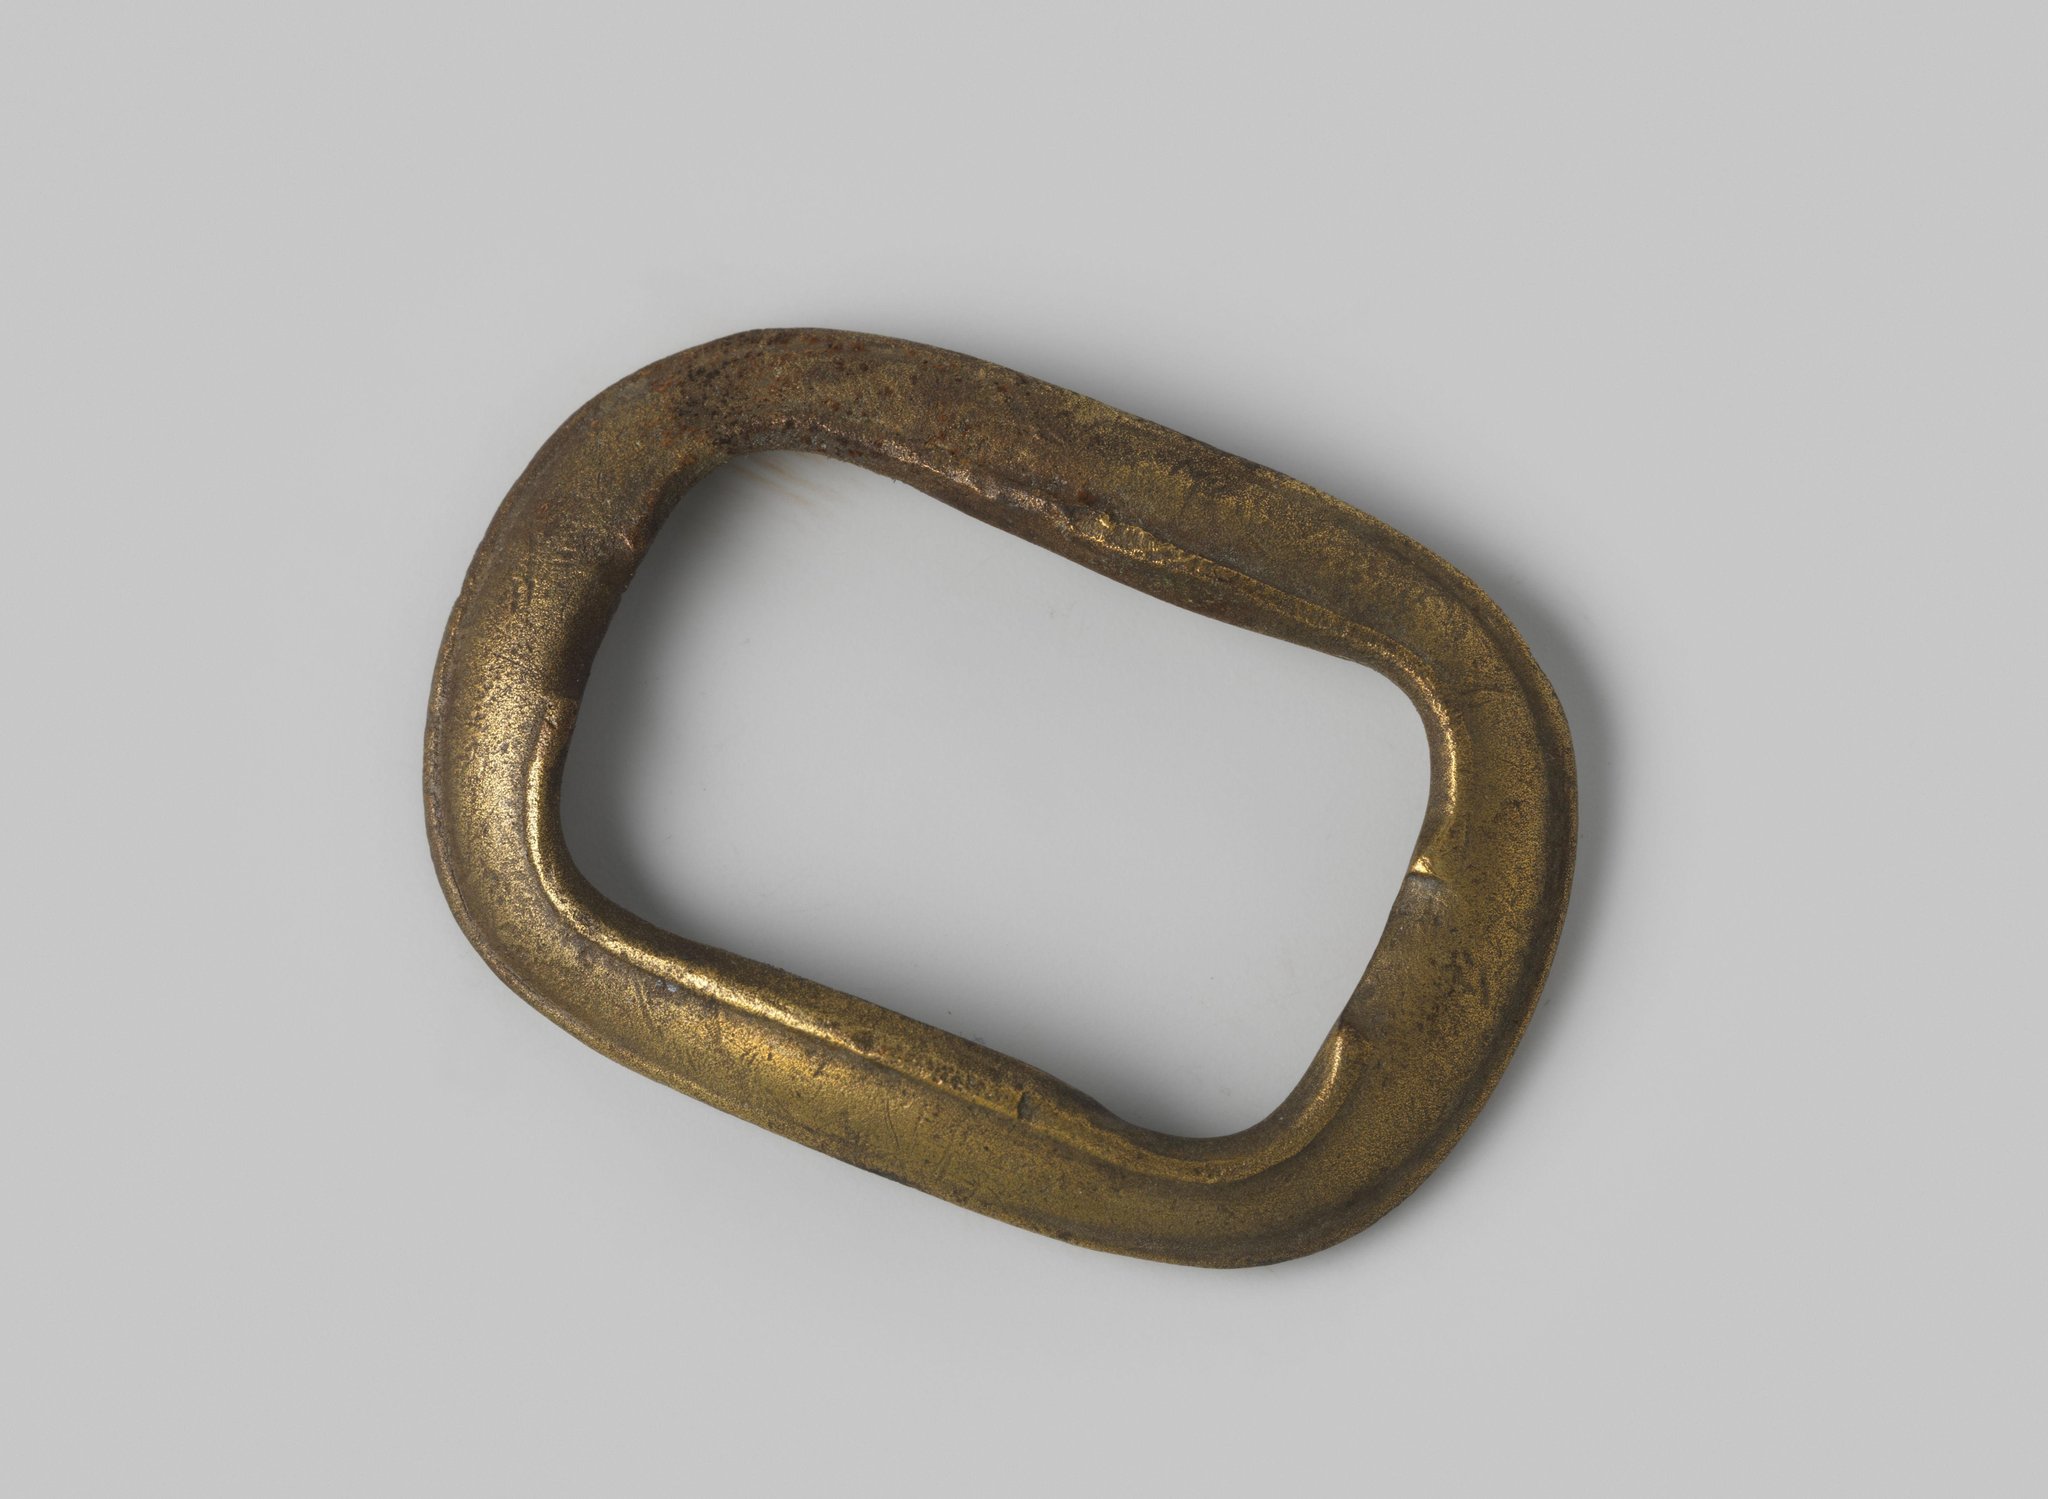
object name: shoe buckle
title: Schoengesp uit het wrak van de Oost-Indiëvaarder Hollandia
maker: Anonymous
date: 1700-1743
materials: copper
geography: netherlands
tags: verenigde oostindische compagnie, hollandia (schip), annet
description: Buckle, chape buckle, shoe buckle; ring, moulded.